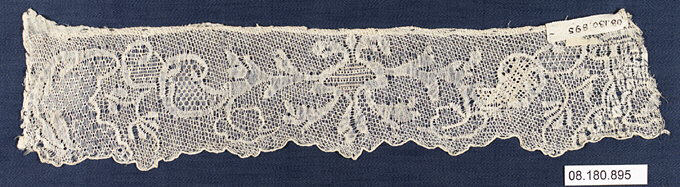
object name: fragment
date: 1701-1800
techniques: embroidery